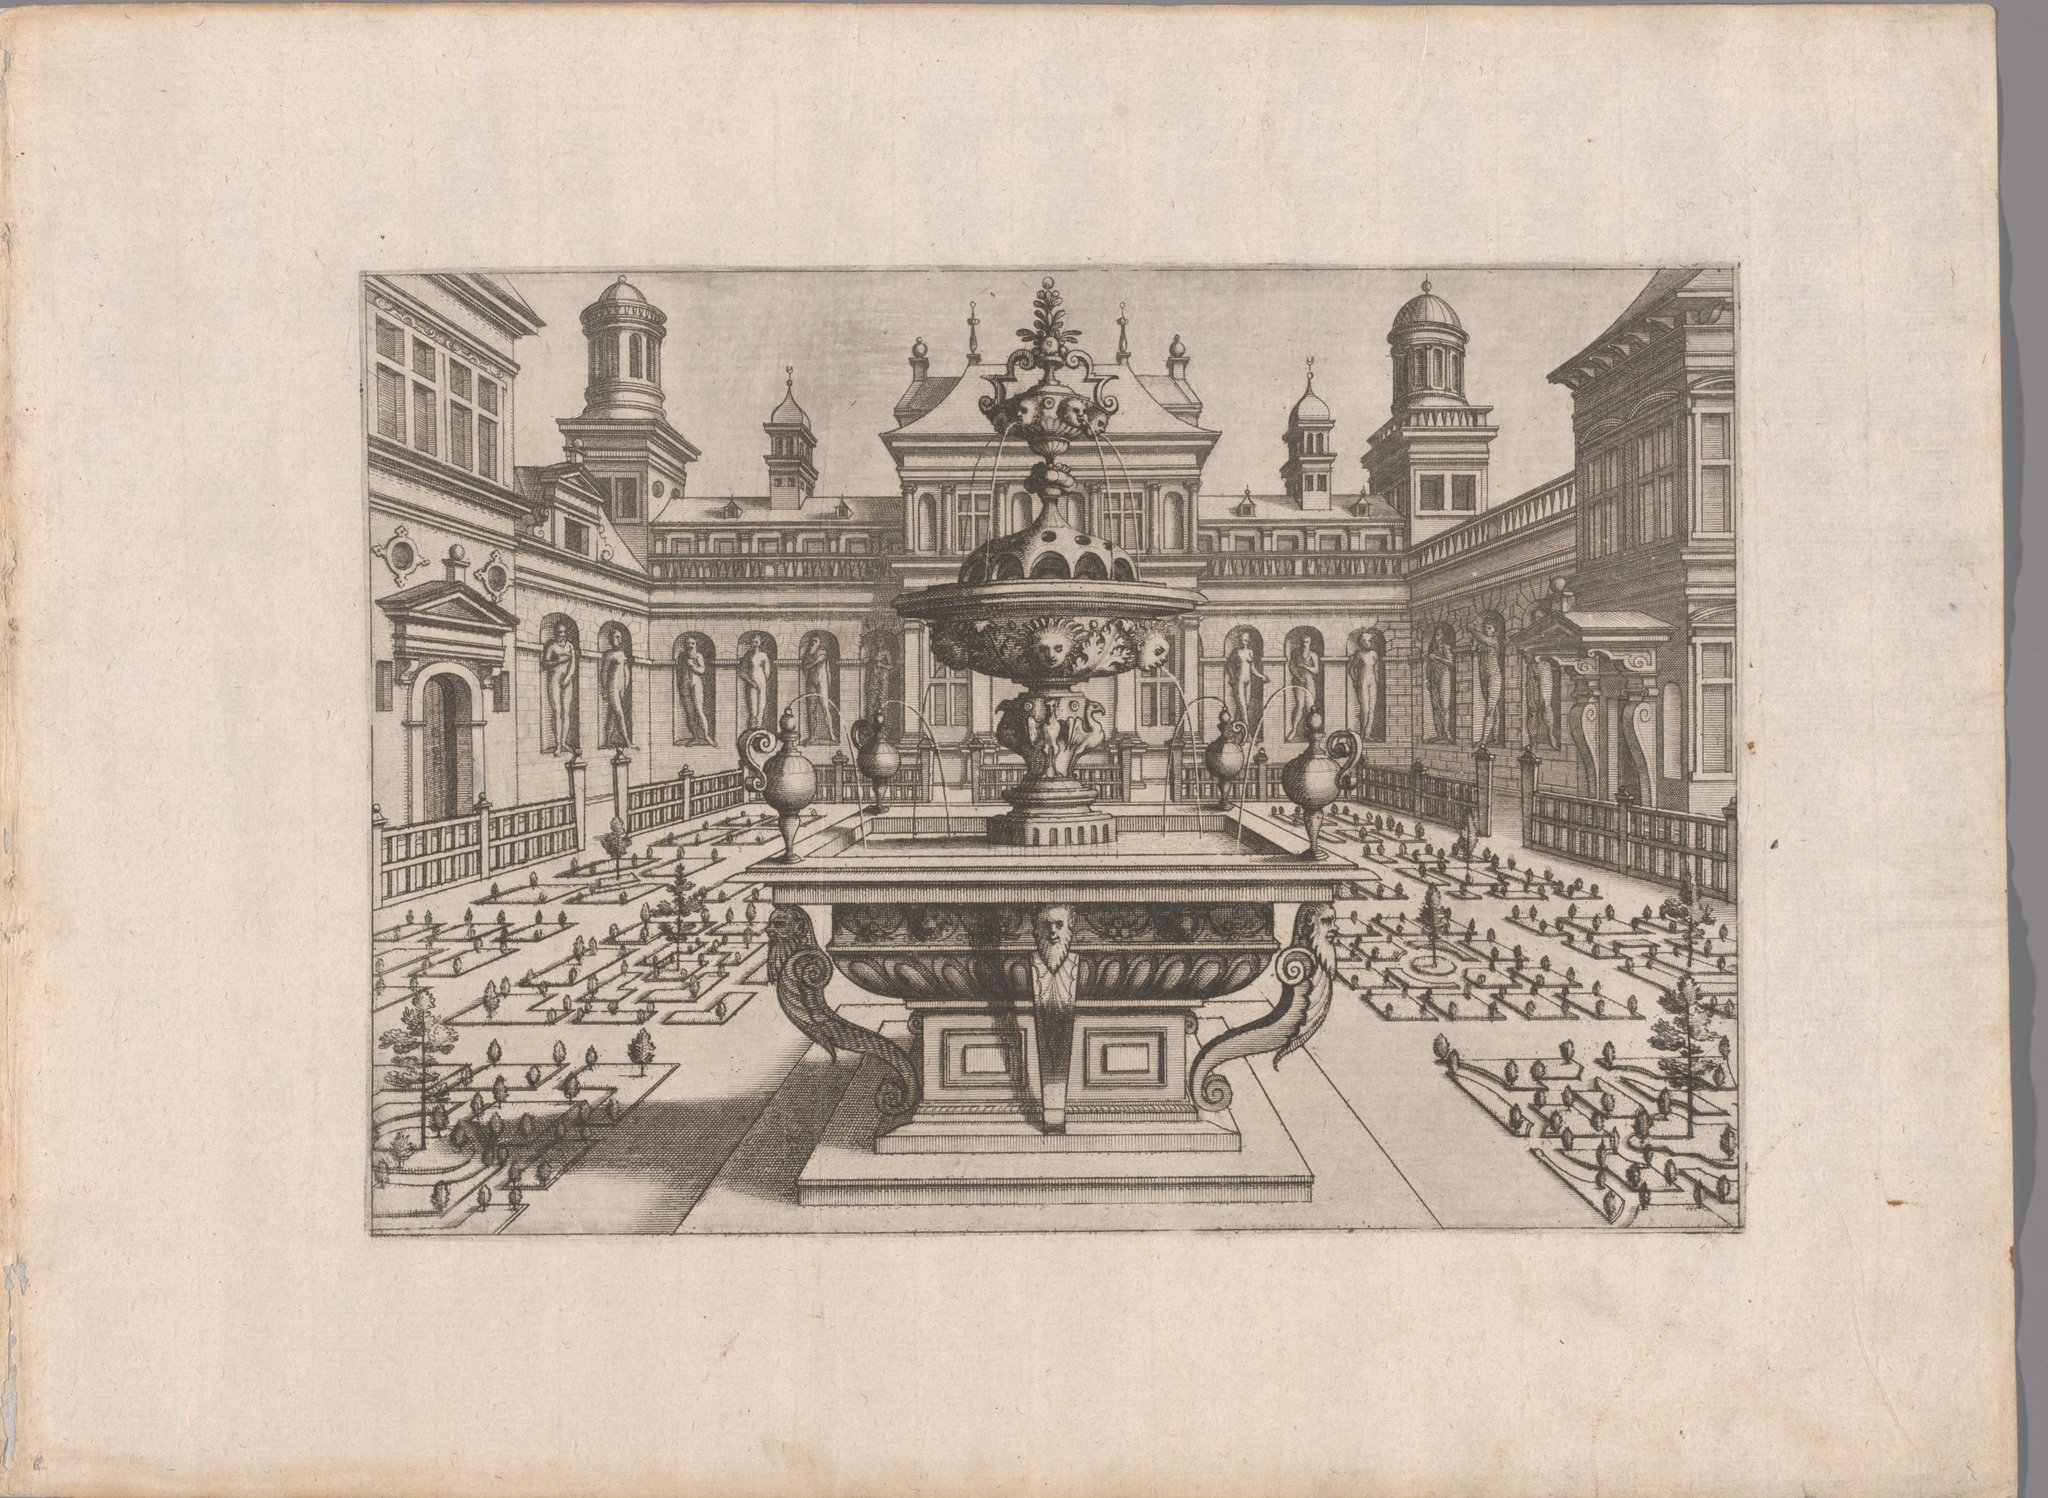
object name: ornament print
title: Binnentuin van een paleis met aan de façade standbeelden in muurnissen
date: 1568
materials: paper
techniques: etching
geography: antwerp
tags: palace, ornamental fountain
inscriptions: collector's mark: Lugt 2228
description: Deel van een ontmanteld album waarvan RP-P-2013-1-54-1 t/m -37, RP-P-2013-1-55-1 en -2 en RP-P-2013-1-63 t/m 67 deel waren.